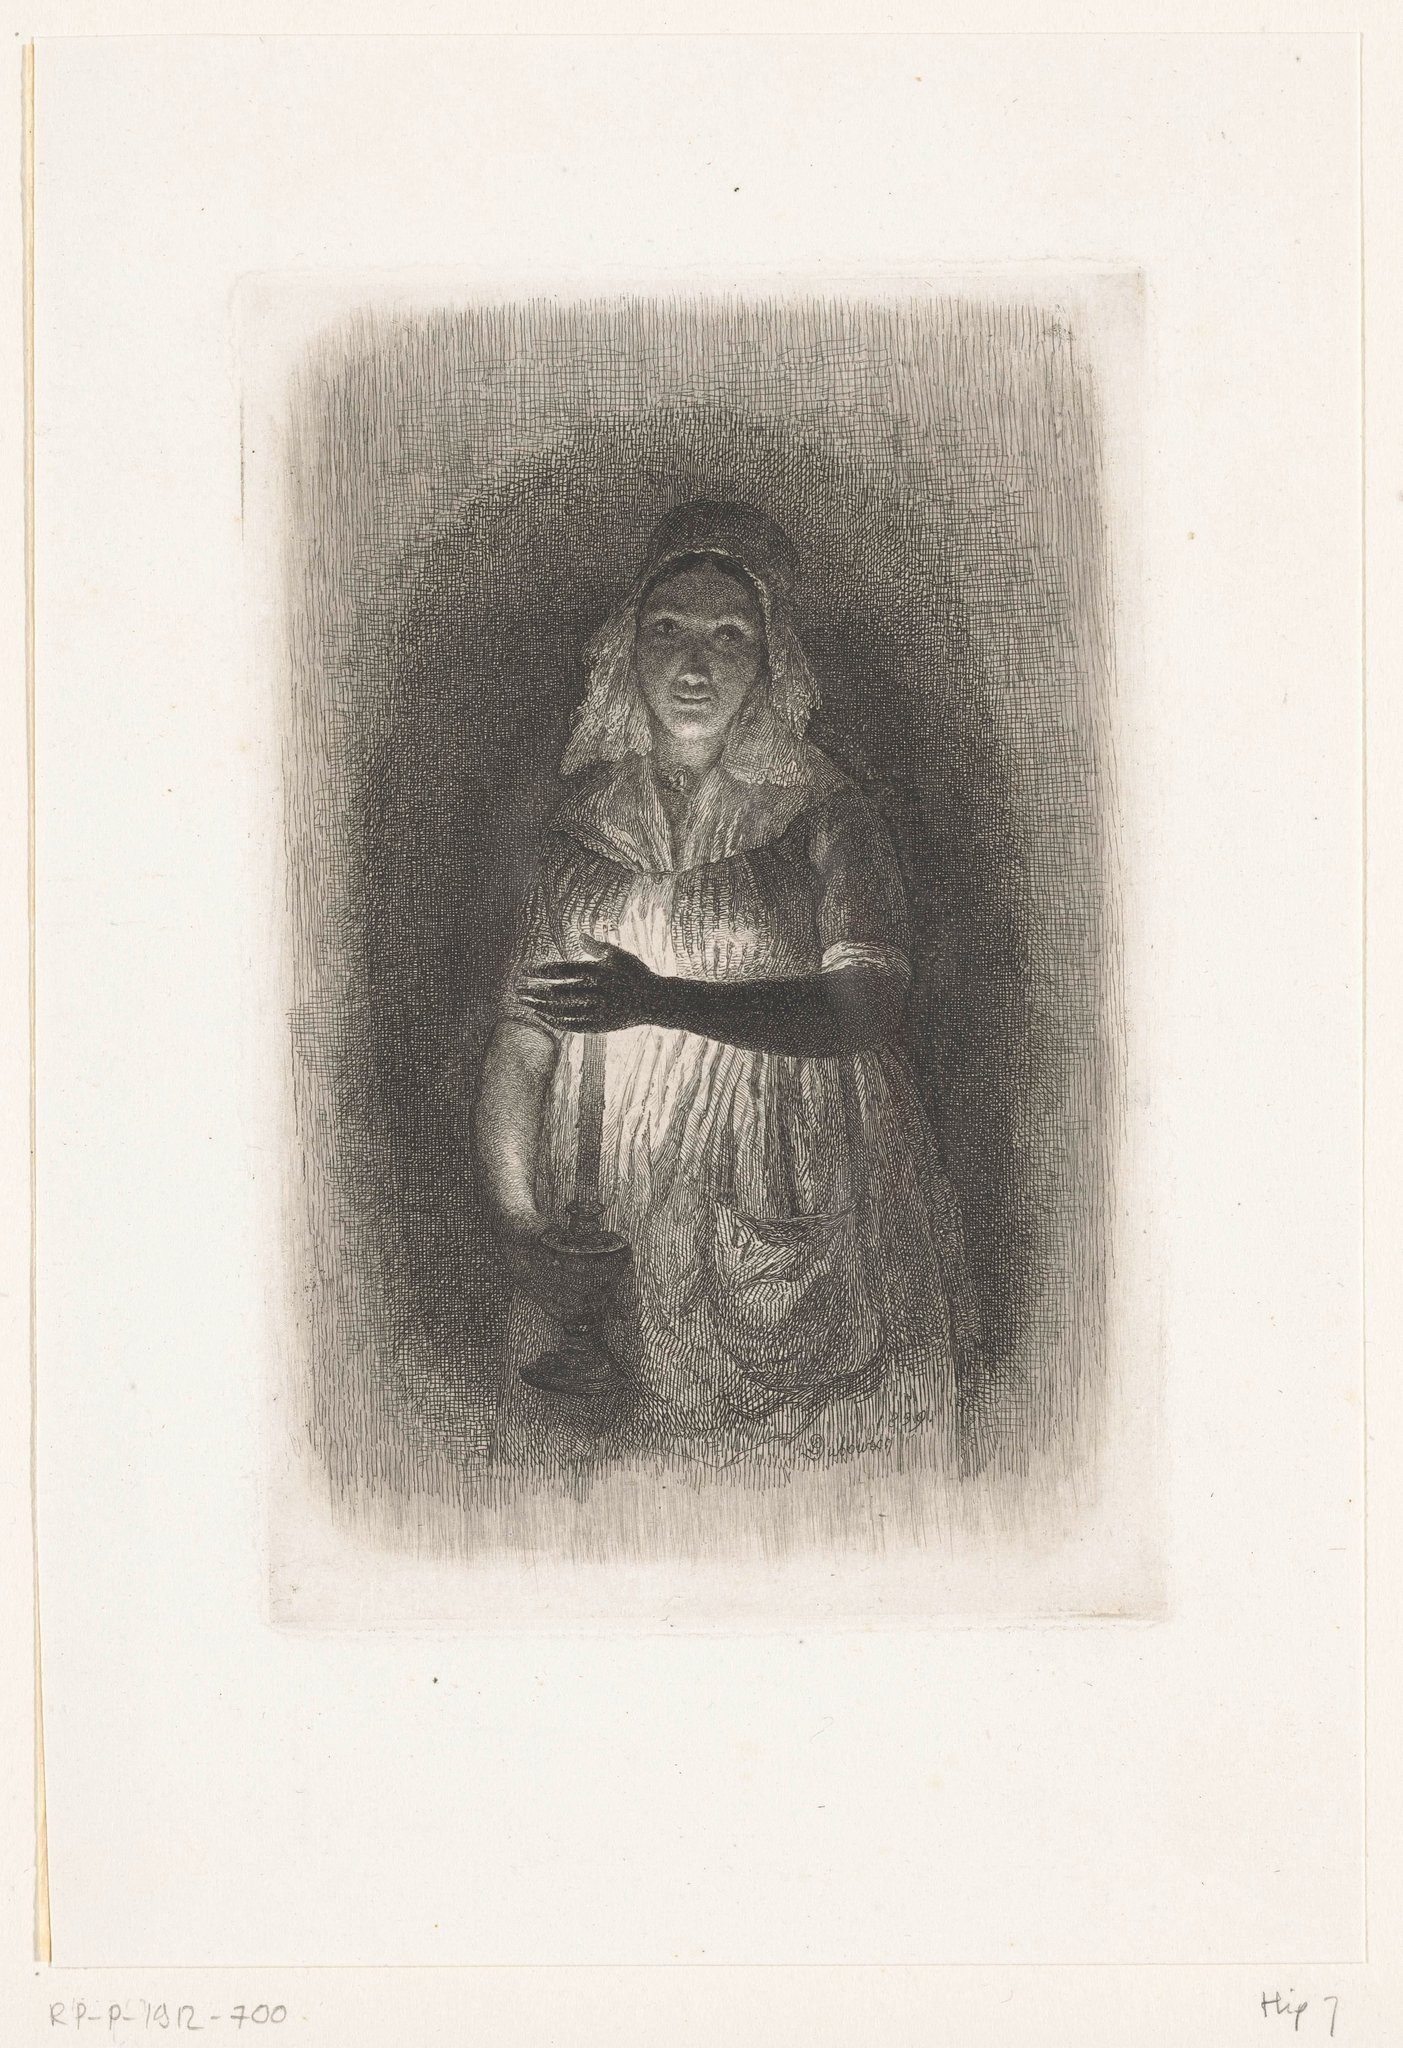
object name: print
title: Vijf etsproeven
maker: pierre louis dubourcq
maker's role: draughtsman, painter, print maker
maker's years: 1815-1873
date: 1839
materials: paper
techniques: drypoint, etching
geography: netherlands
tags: maid ~ house personnel, chandelier, candelabrum (+ kindling a light; lit, burning light, lamp, candle)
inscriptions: collector's mark: Lugt 2228